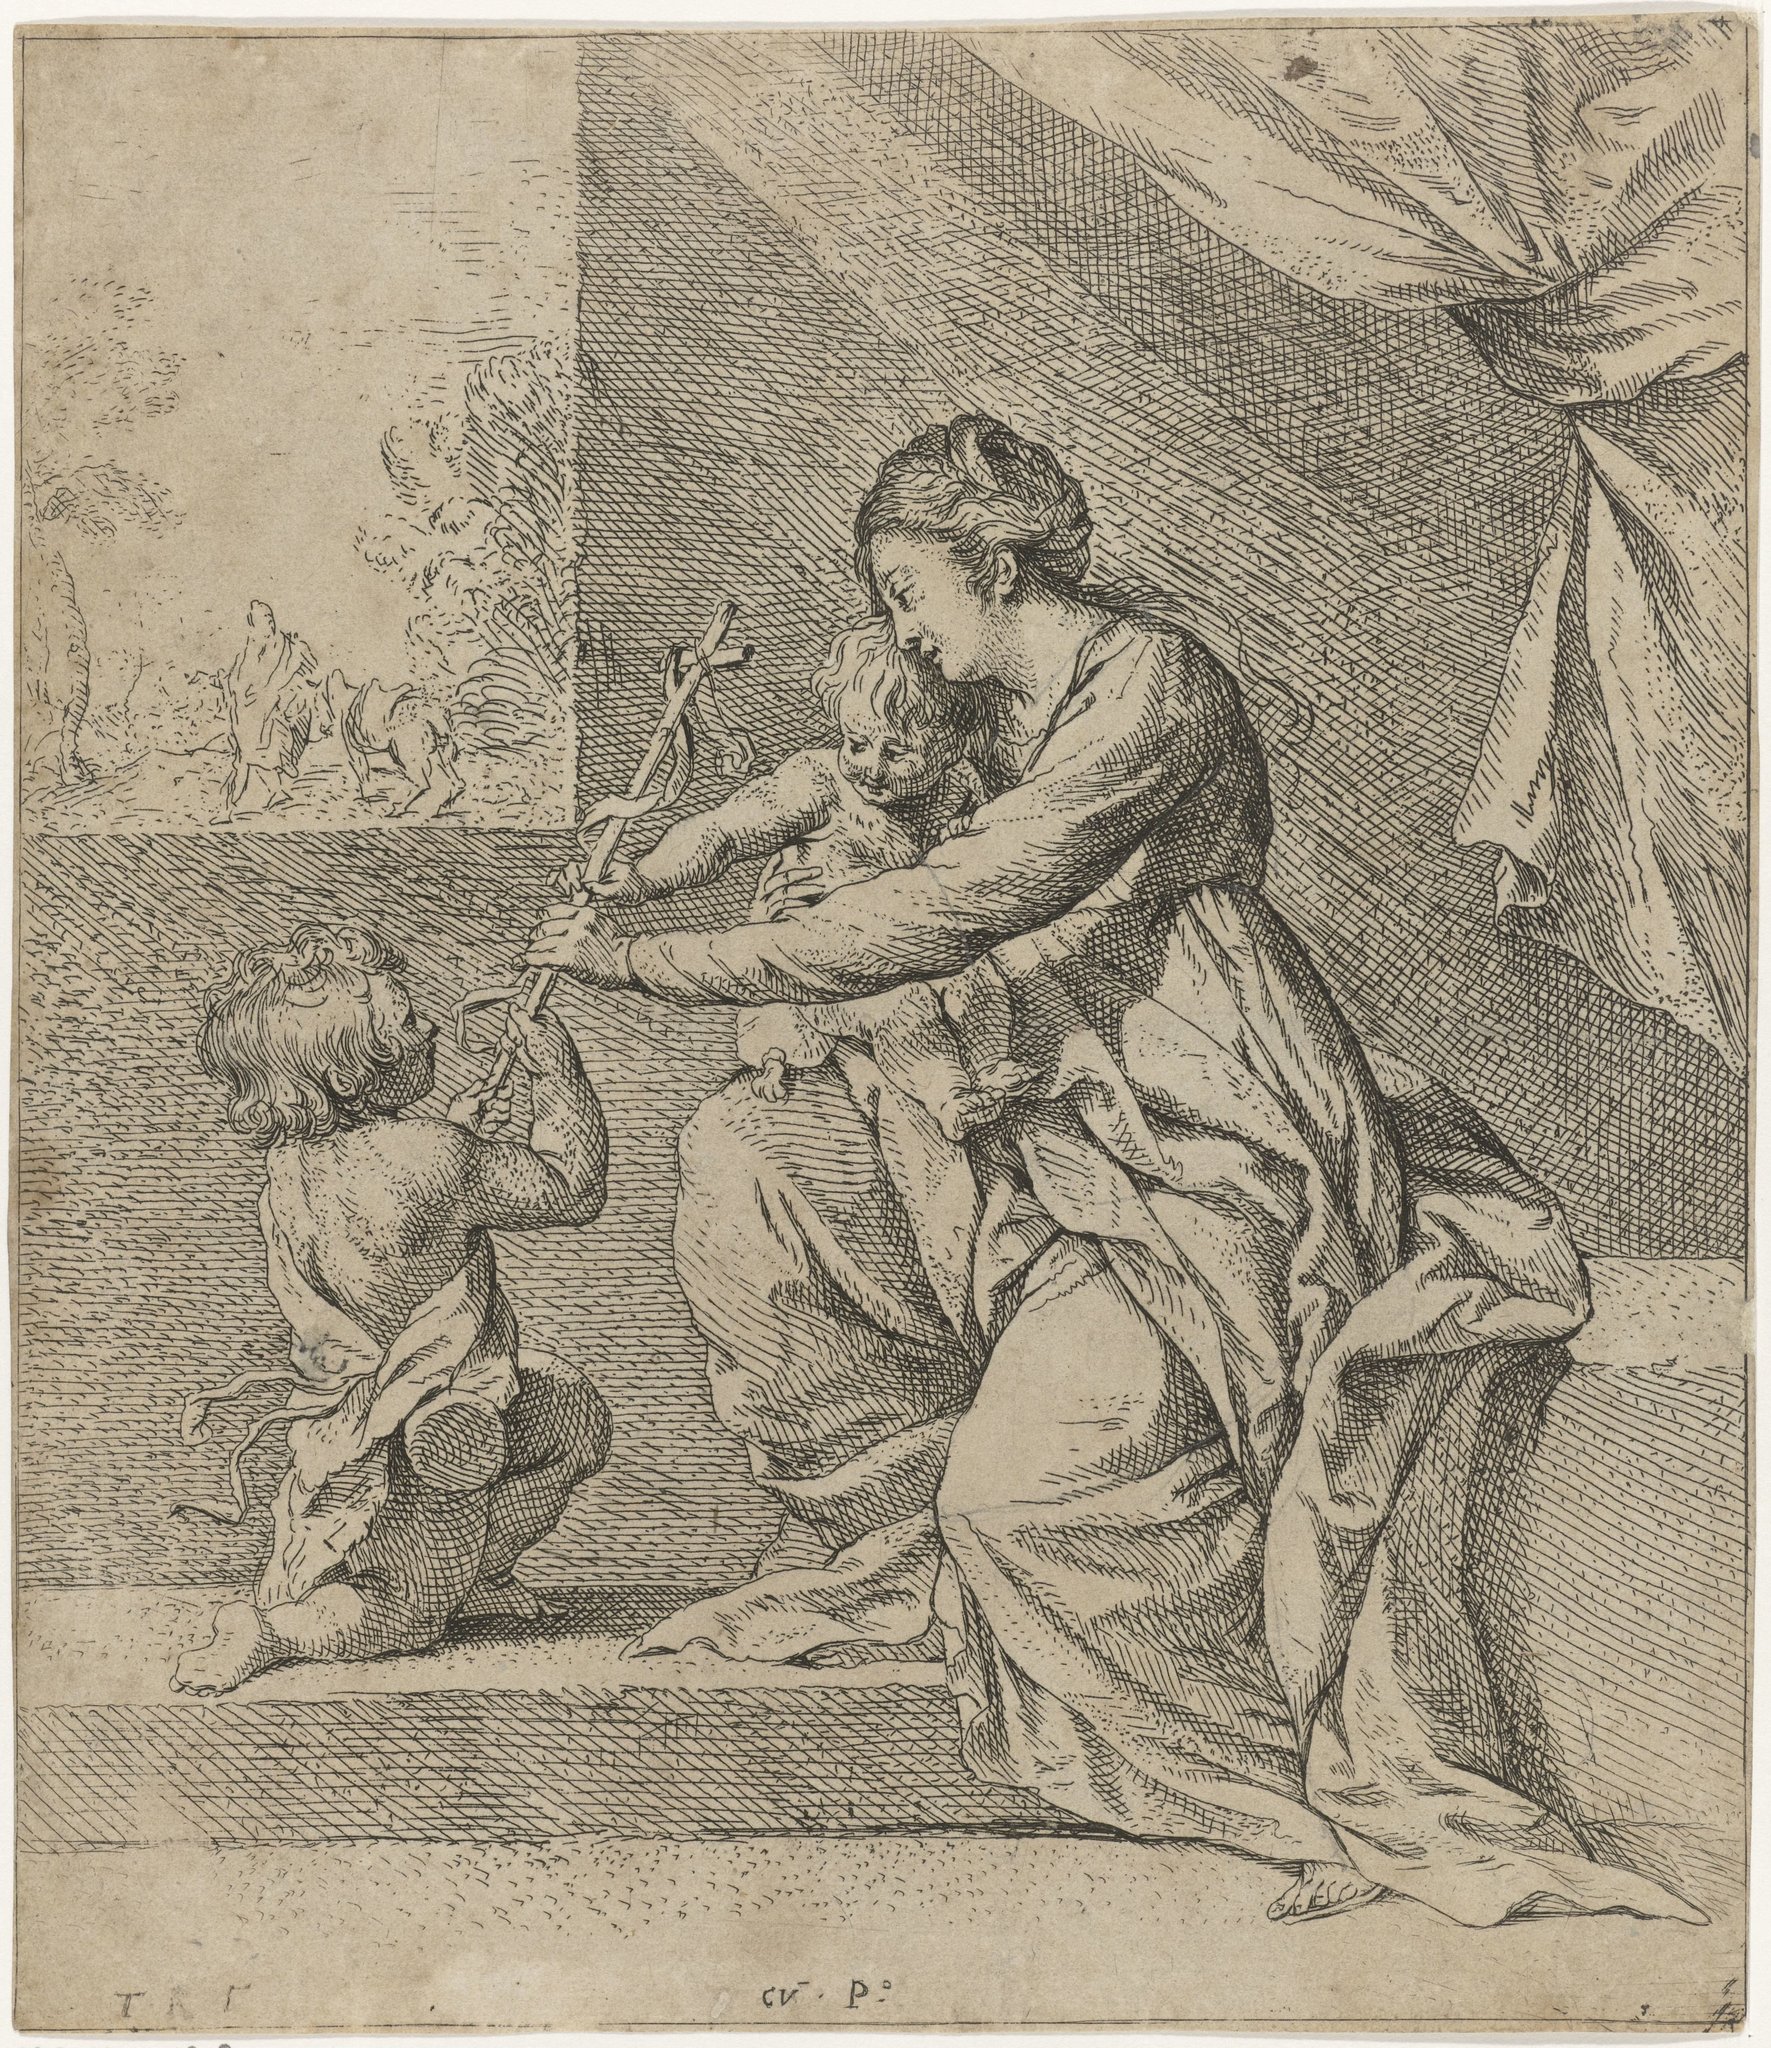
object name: print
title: Maria met Christus en Johannes de Doper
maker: theodoor rombouts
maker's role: print maker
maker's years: 1597-1637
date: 1607-1637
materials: paper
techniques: etching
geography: antwerp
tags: madonna: mary standing (or half-length), christ-child close to her bosom, ass, donkey, john the baptist as child ~ madonna-representations (n.b. secondary notation only)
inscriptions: collector's mark: Lugt 2165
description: In een vertrek zit Johannes de Doper (als kind) geknield voor Maria, die het Christuskind op schoot heeft. Door een venster is een man met een ezel te zien.